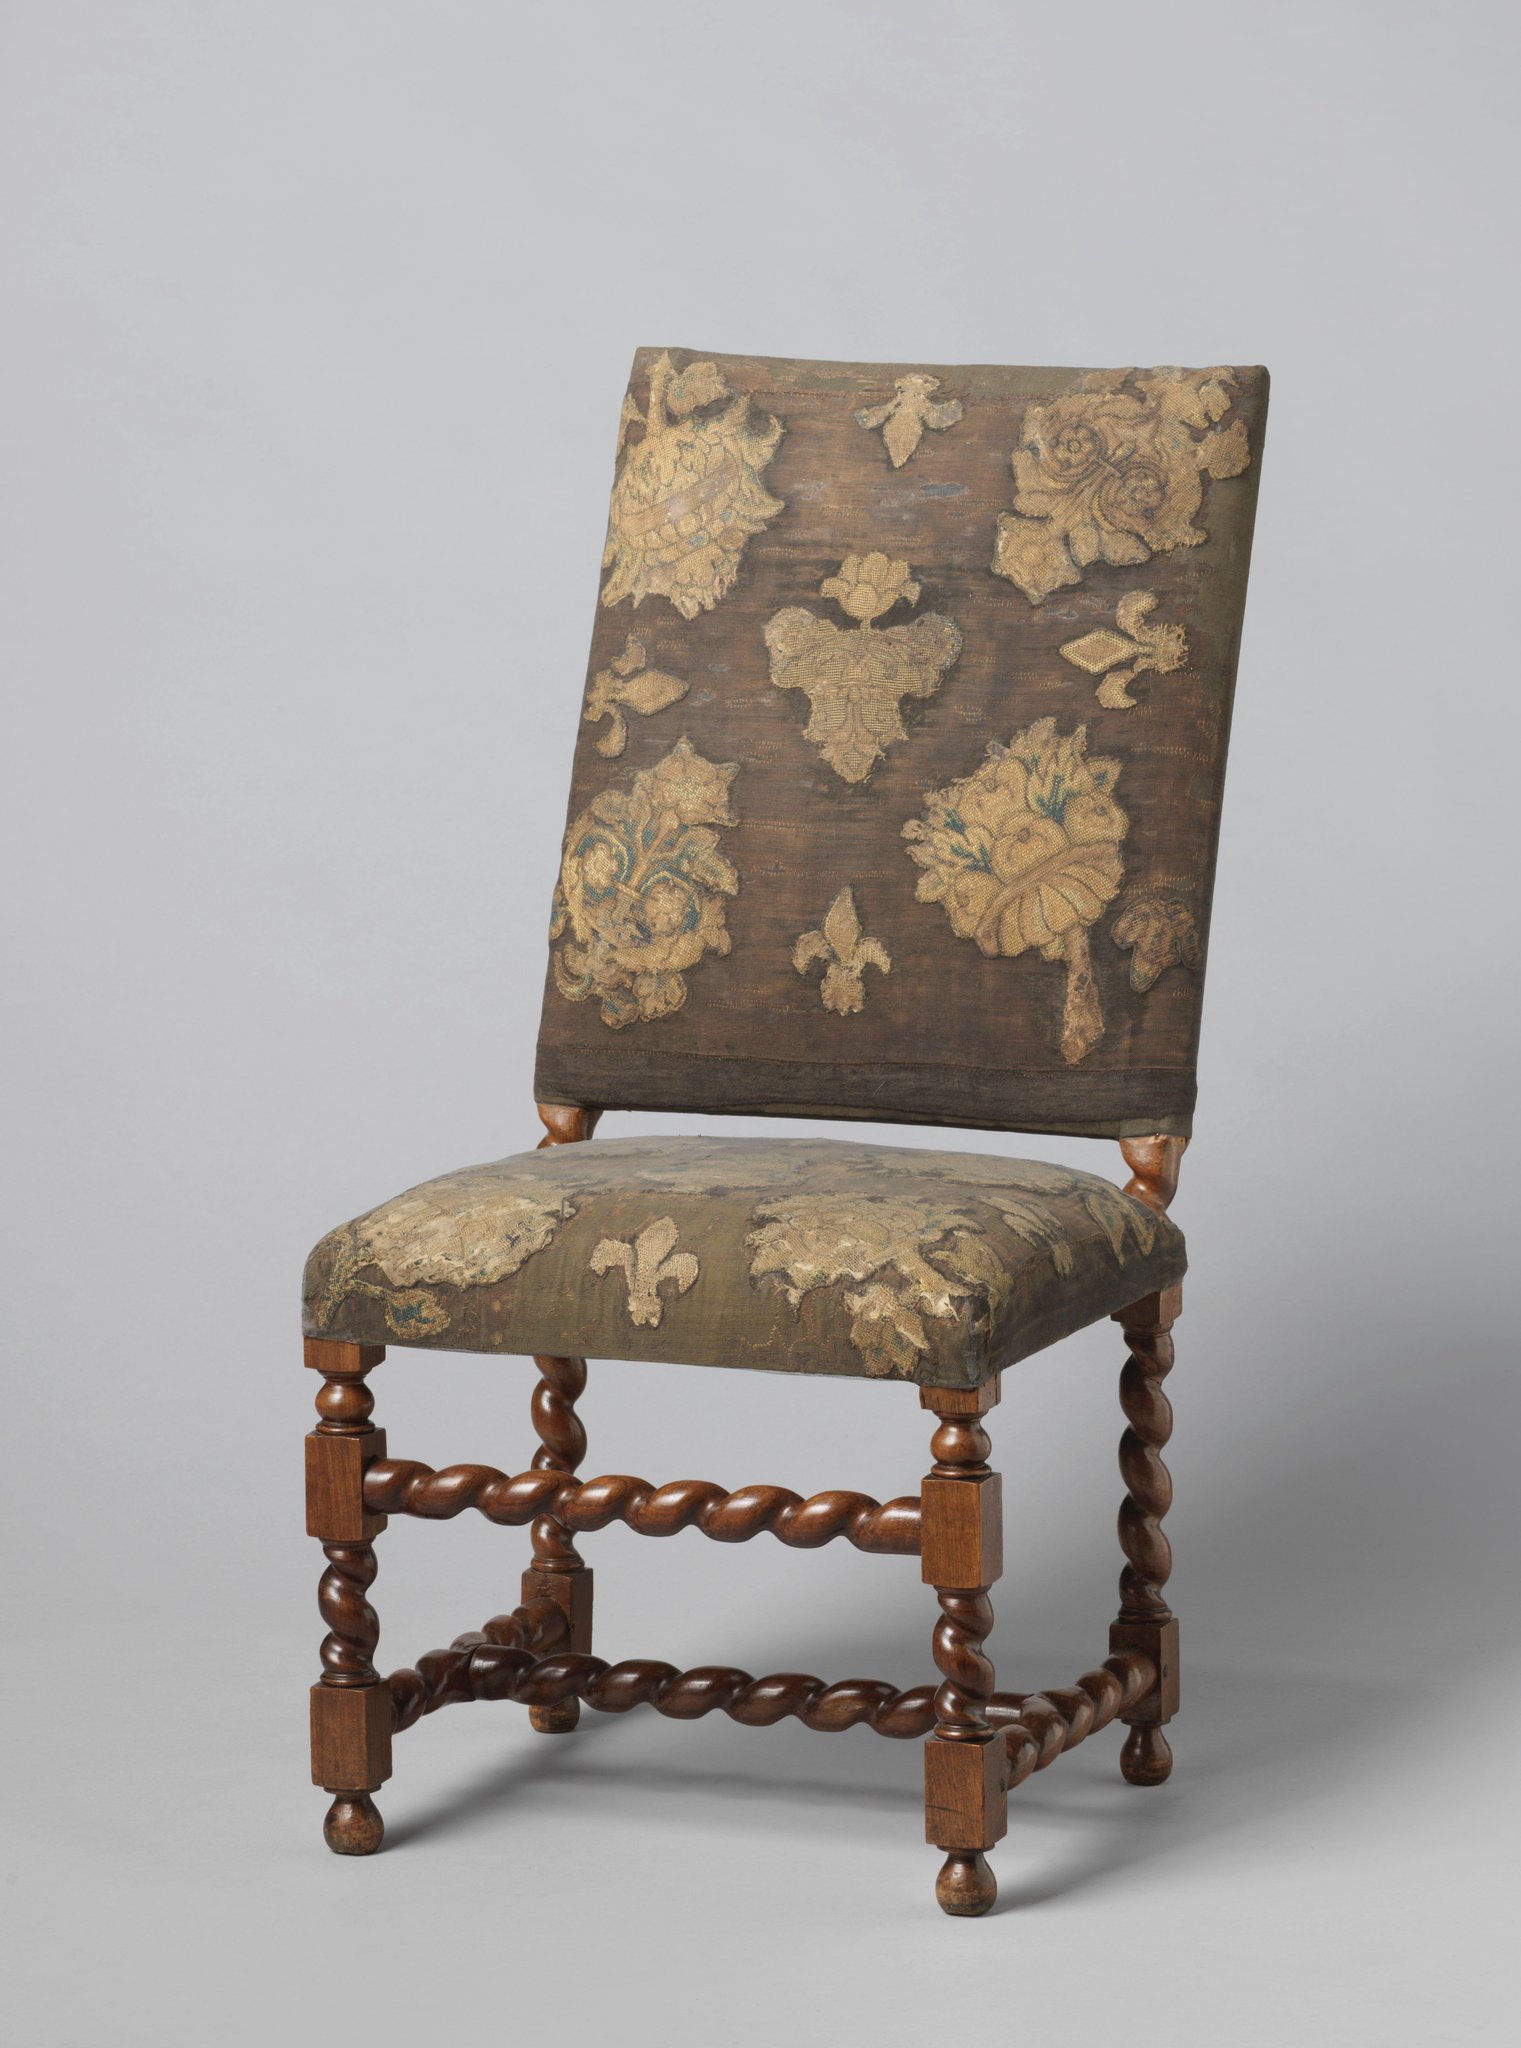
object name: furniture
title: Meubilair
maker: Anonymous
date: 1650-1700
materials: velvet, wood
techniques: damask, tapestry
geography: northern netherlands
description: Six chairs. Walnut, velvet and tapestry. Northern Netherlands, 2nd half 17th century.